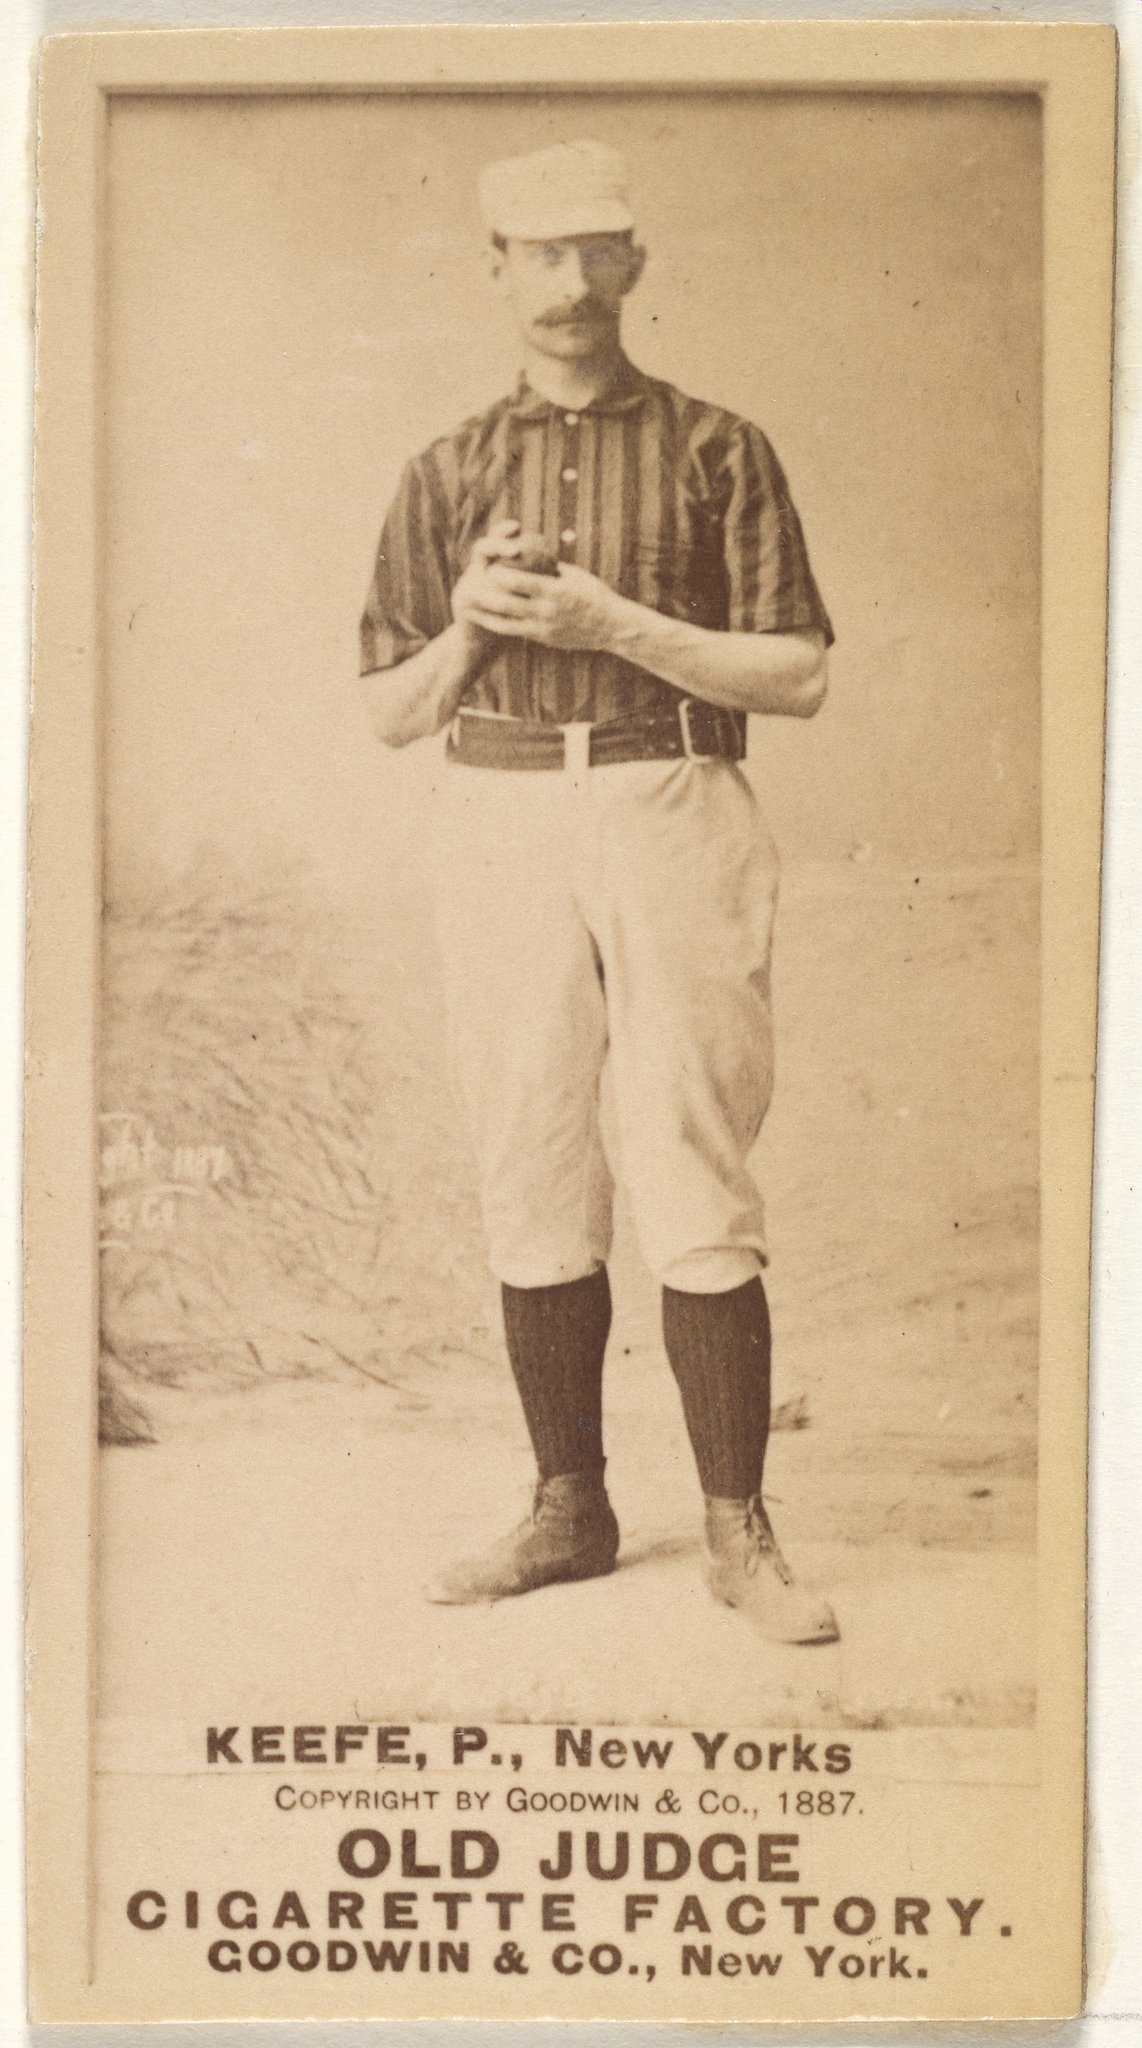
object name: baseball card, photograph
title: Timothy John "Tim" Keefe, Pitcher, New York, from the Old Judge series (N172) for Old Judge Cigarettes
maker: goodwin & company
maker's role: publisher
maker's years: 1850-1950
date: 1887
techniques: albumen silver print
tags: men,portraits,baseball,athletes